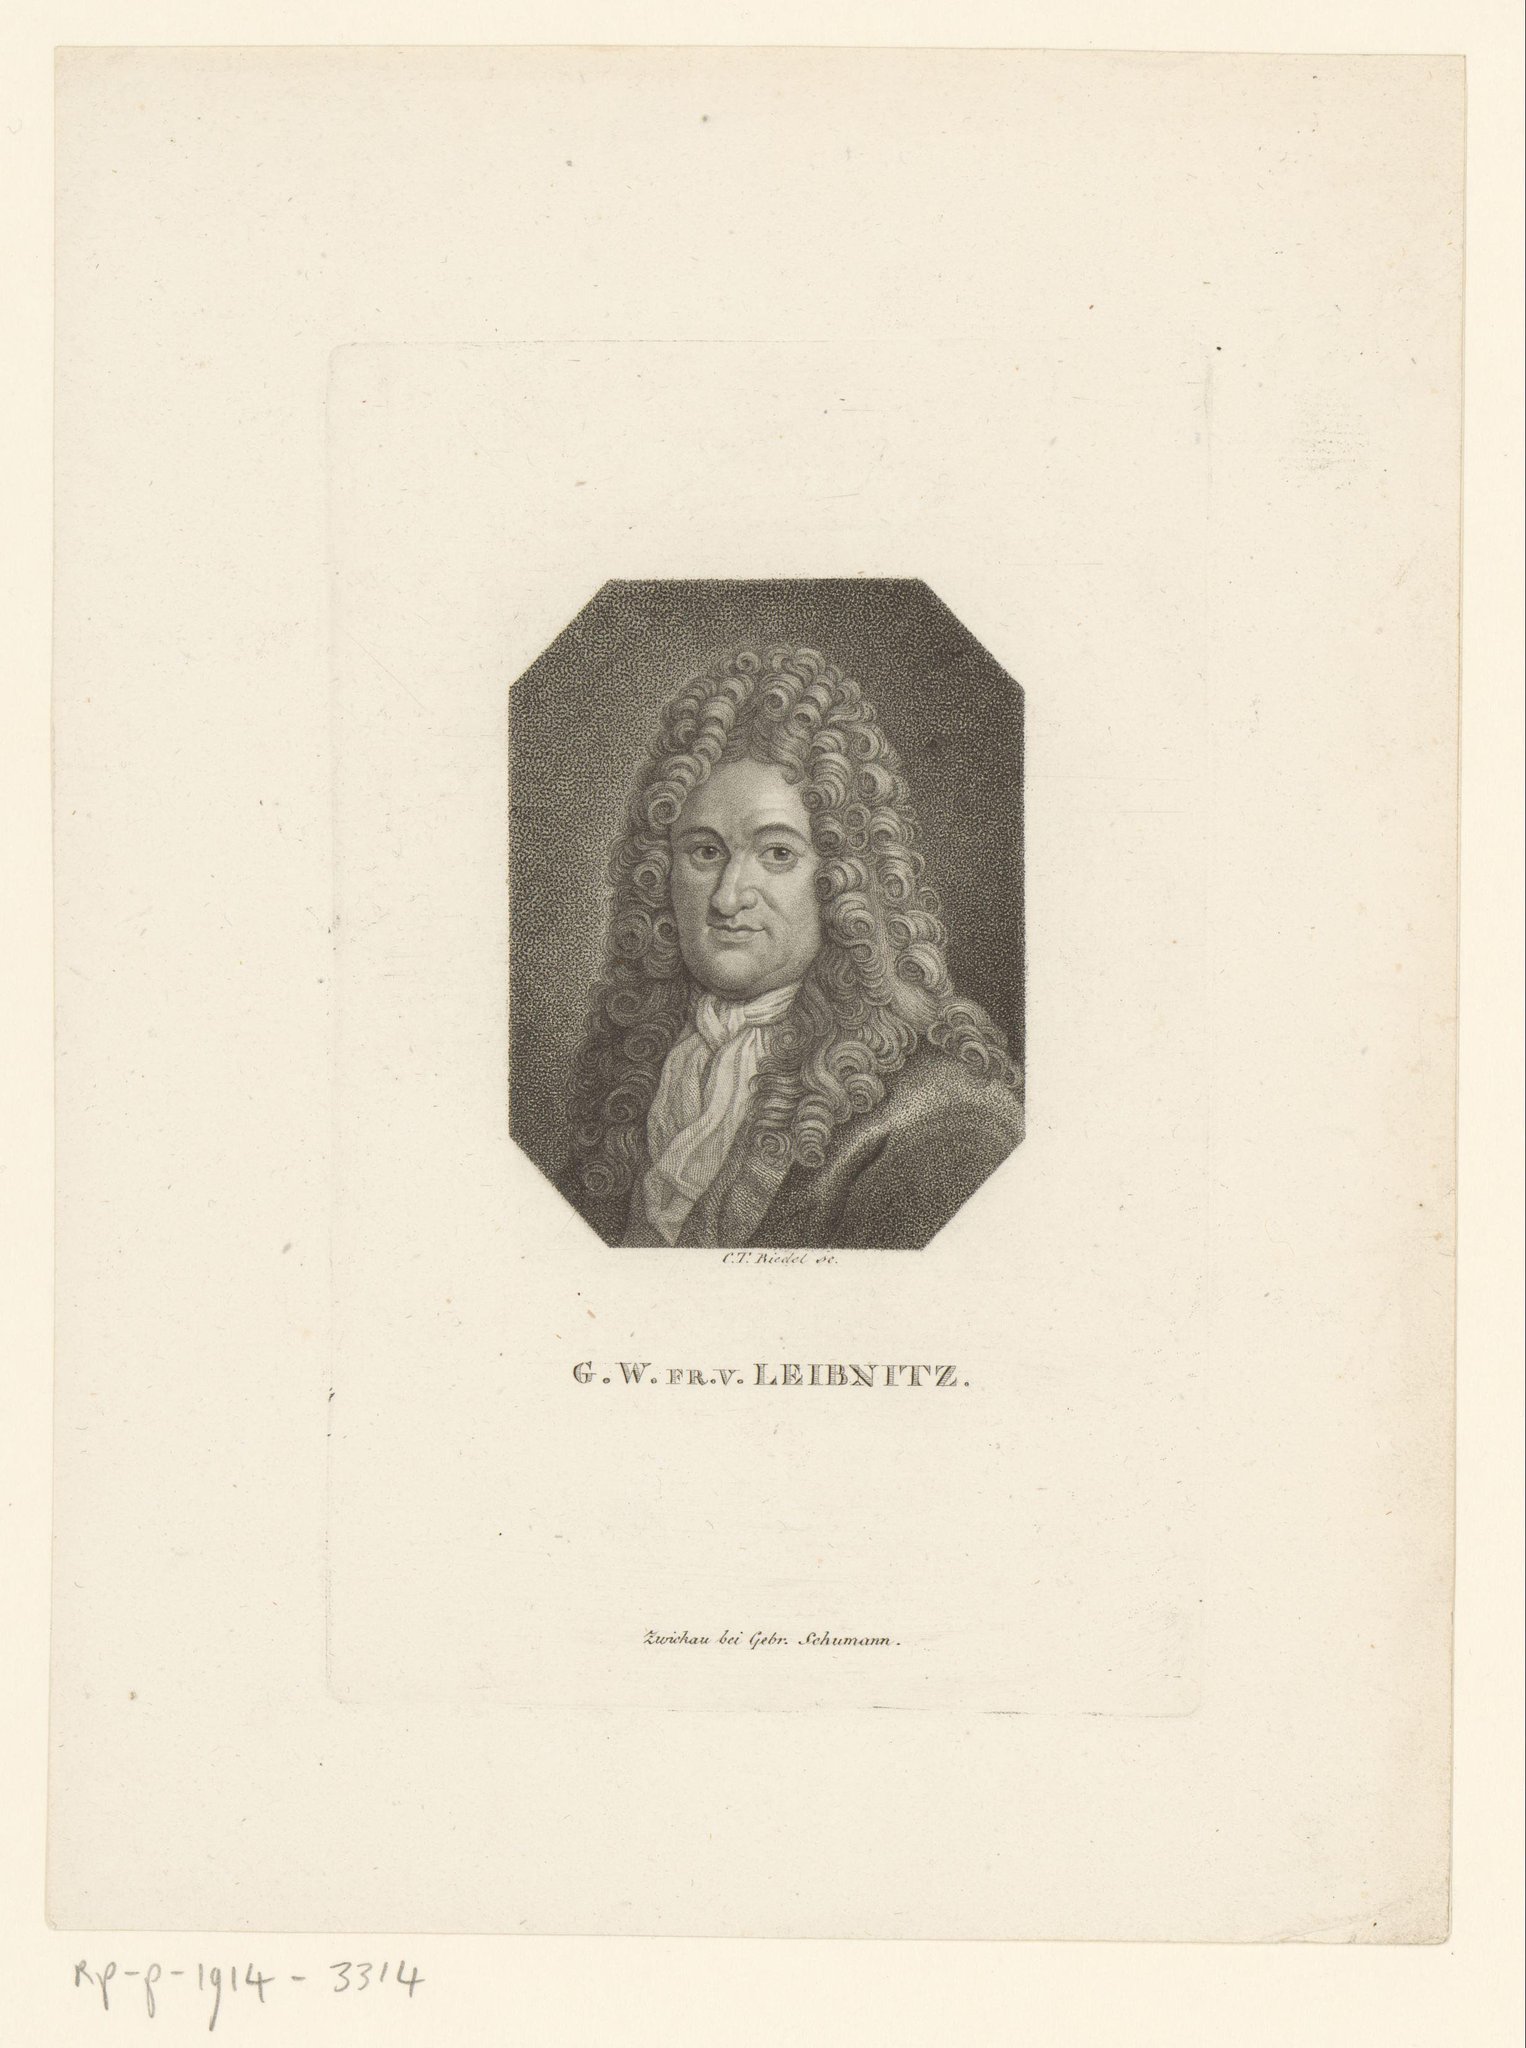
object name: print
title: Portret van Gottfried Wilhelm Leibniz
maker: karl traugott riedel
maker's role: print maker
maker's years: 1769-1832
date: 1779-1850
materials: paper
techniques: engraving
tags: historical persons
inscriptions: collector's mark: Lugt 2228